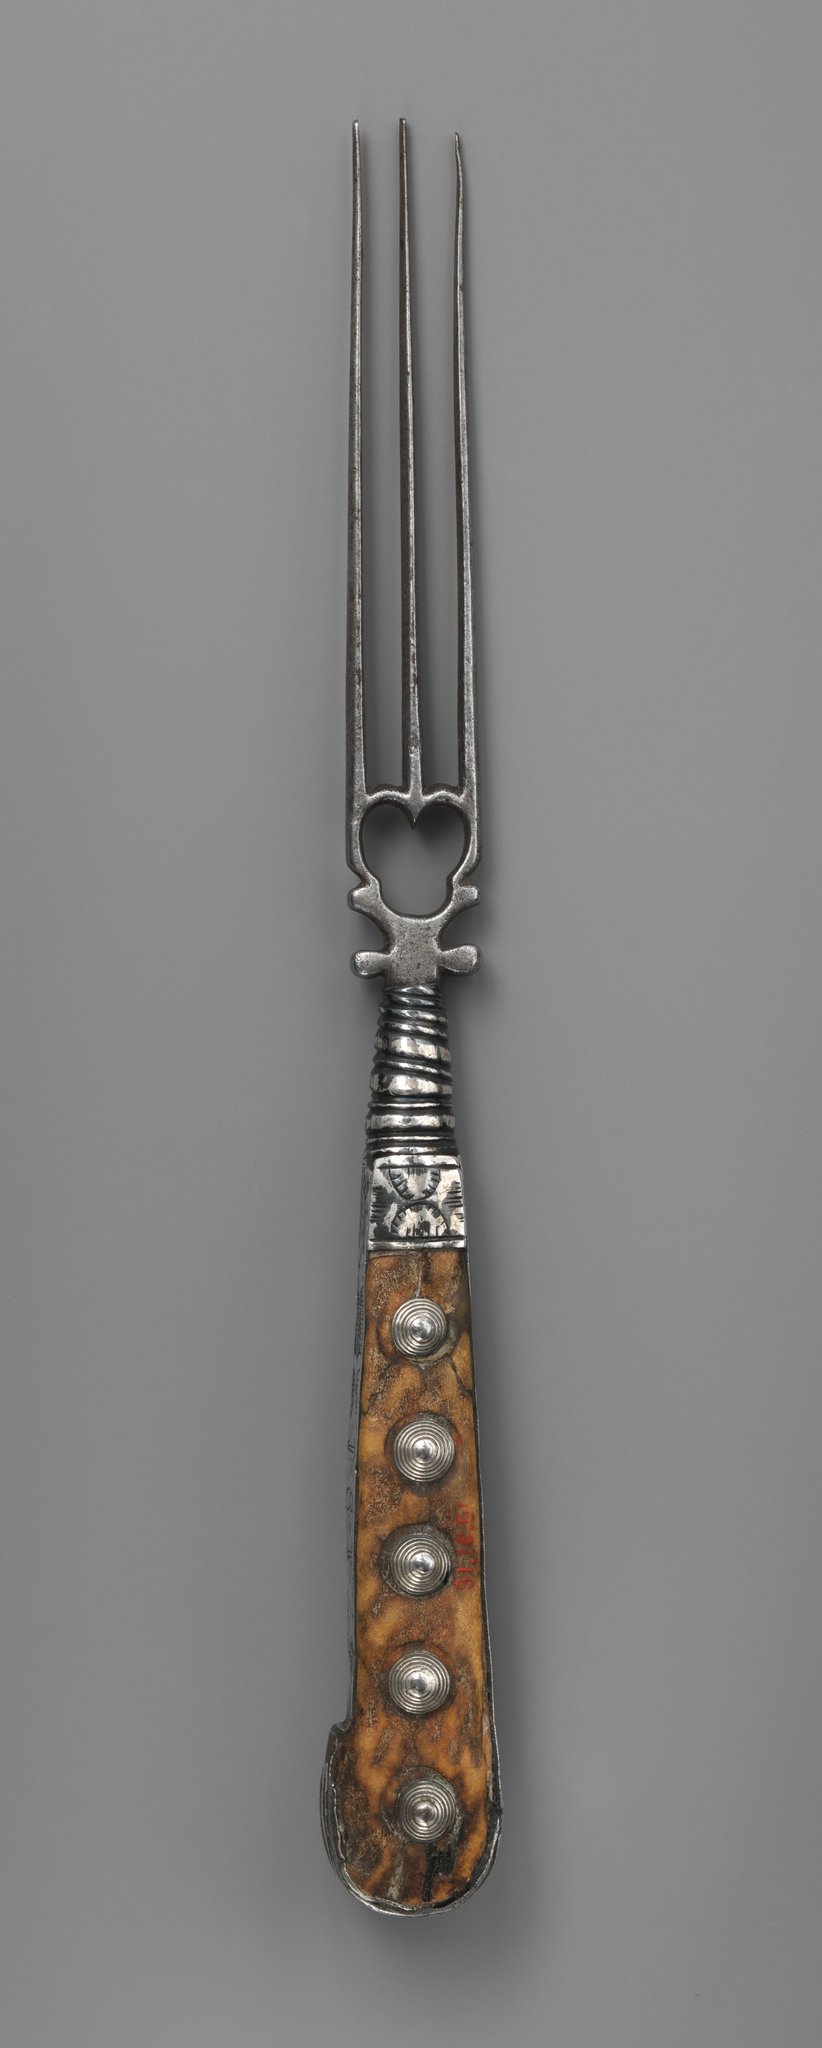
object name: table fork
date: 1815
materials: silver, steel